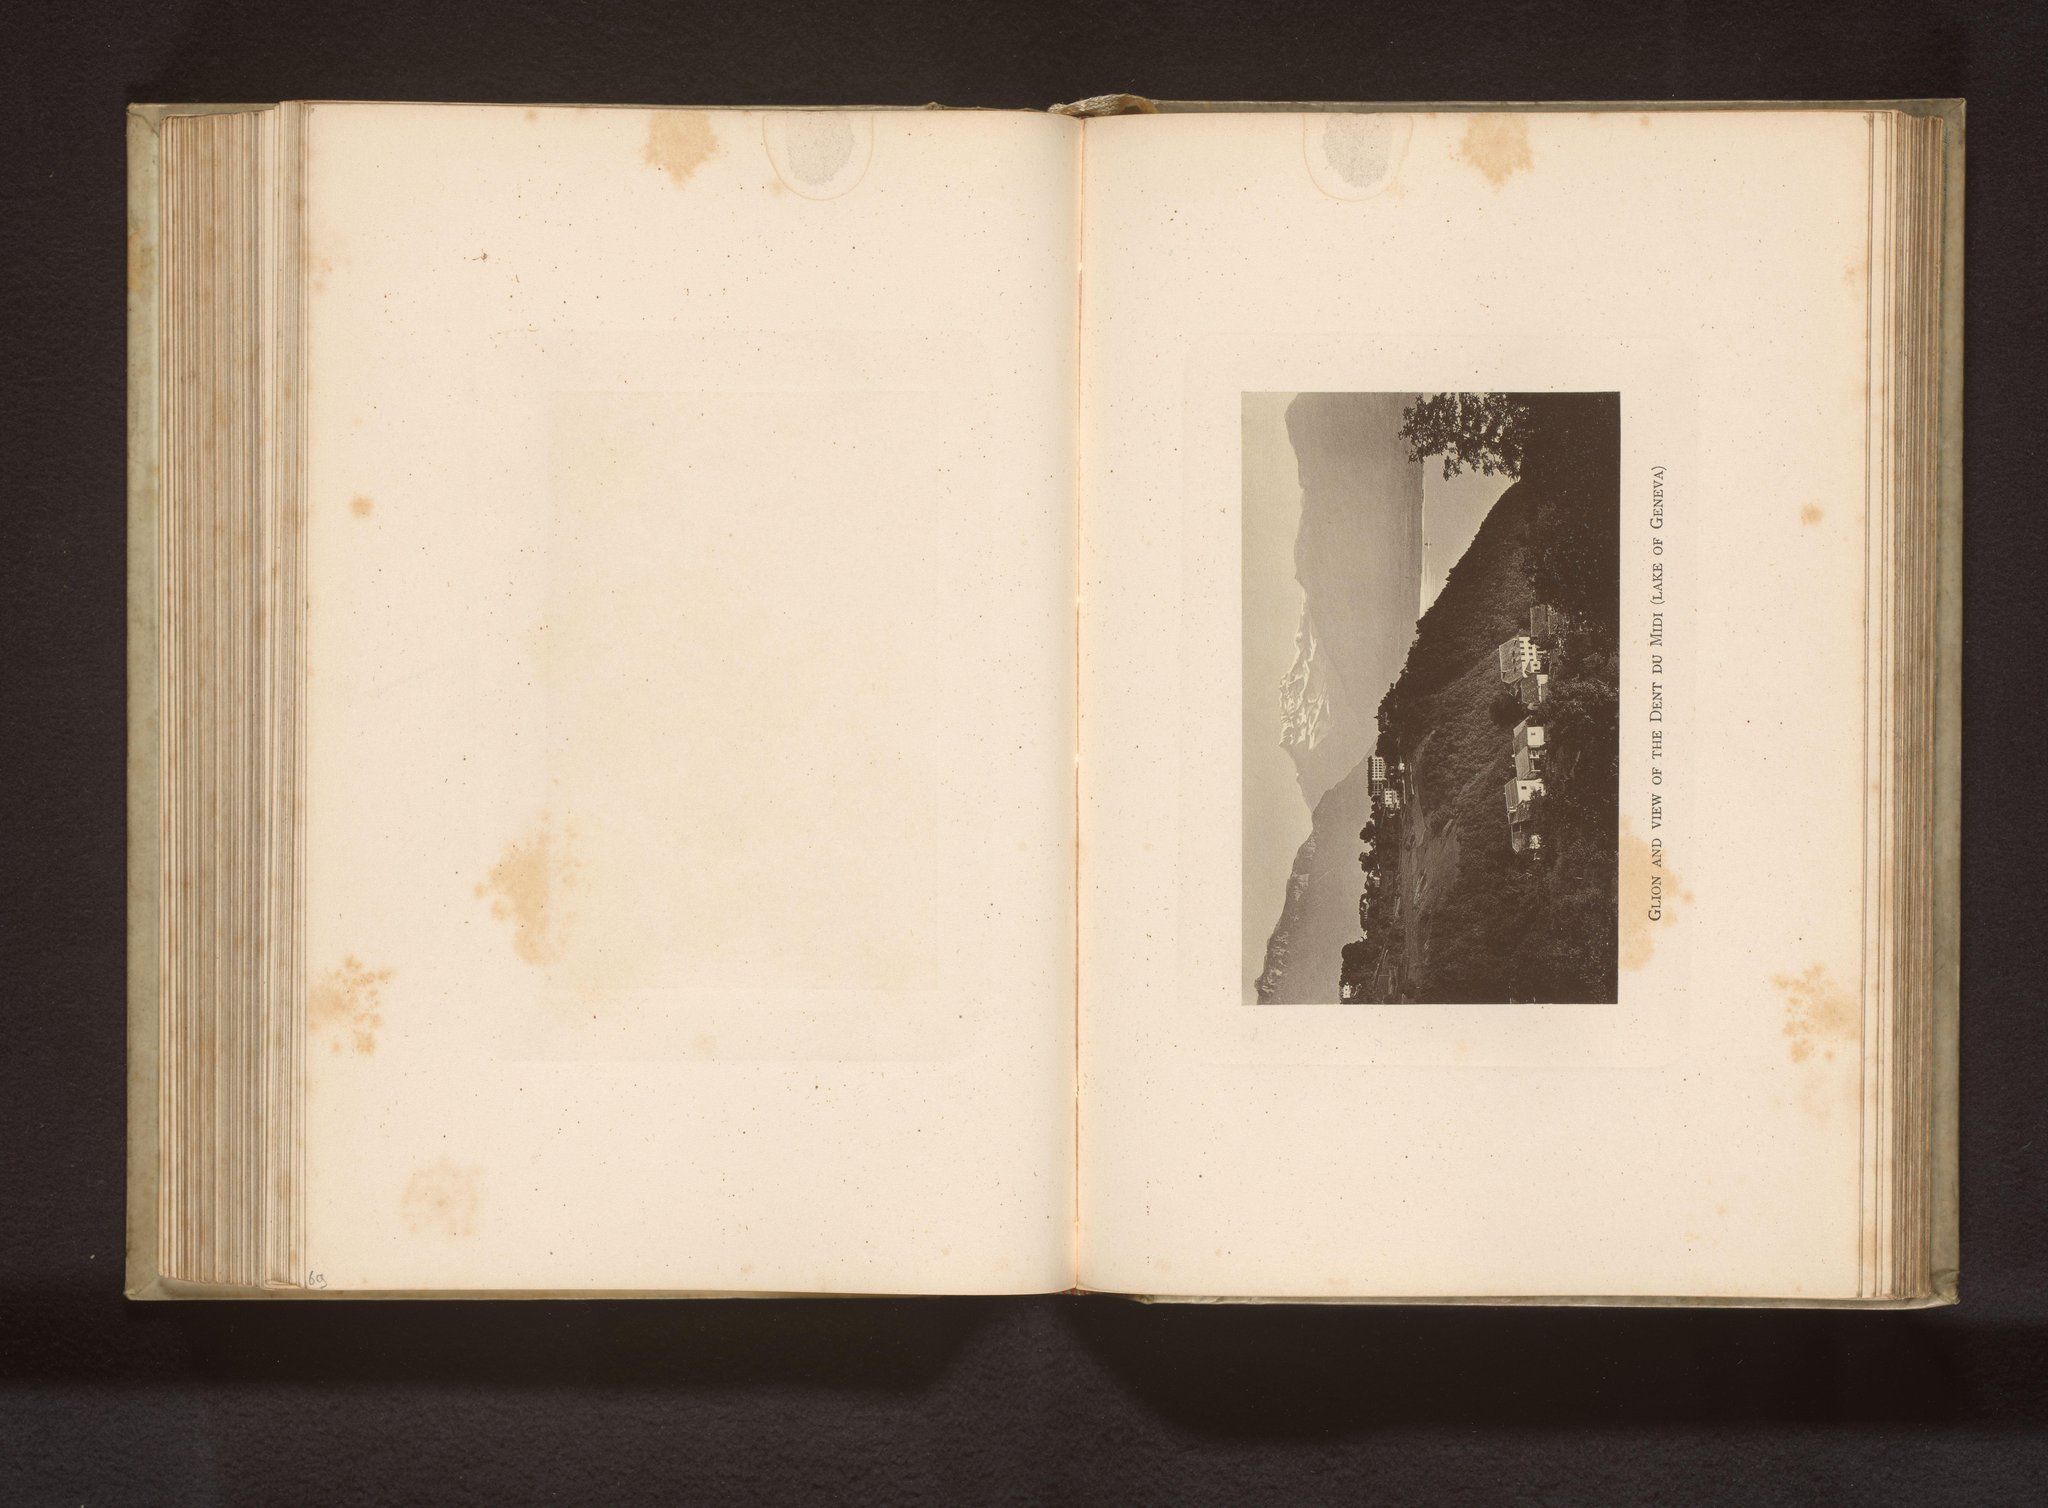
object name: page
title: Gezicht op Glion aan het meer van Genève en daarachter de Dents du Midi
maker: Anonymous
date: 1874-1884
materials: paper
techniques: photograph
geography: montreux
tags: lake, prospect of city, town panorama, silhouette of city, mountains